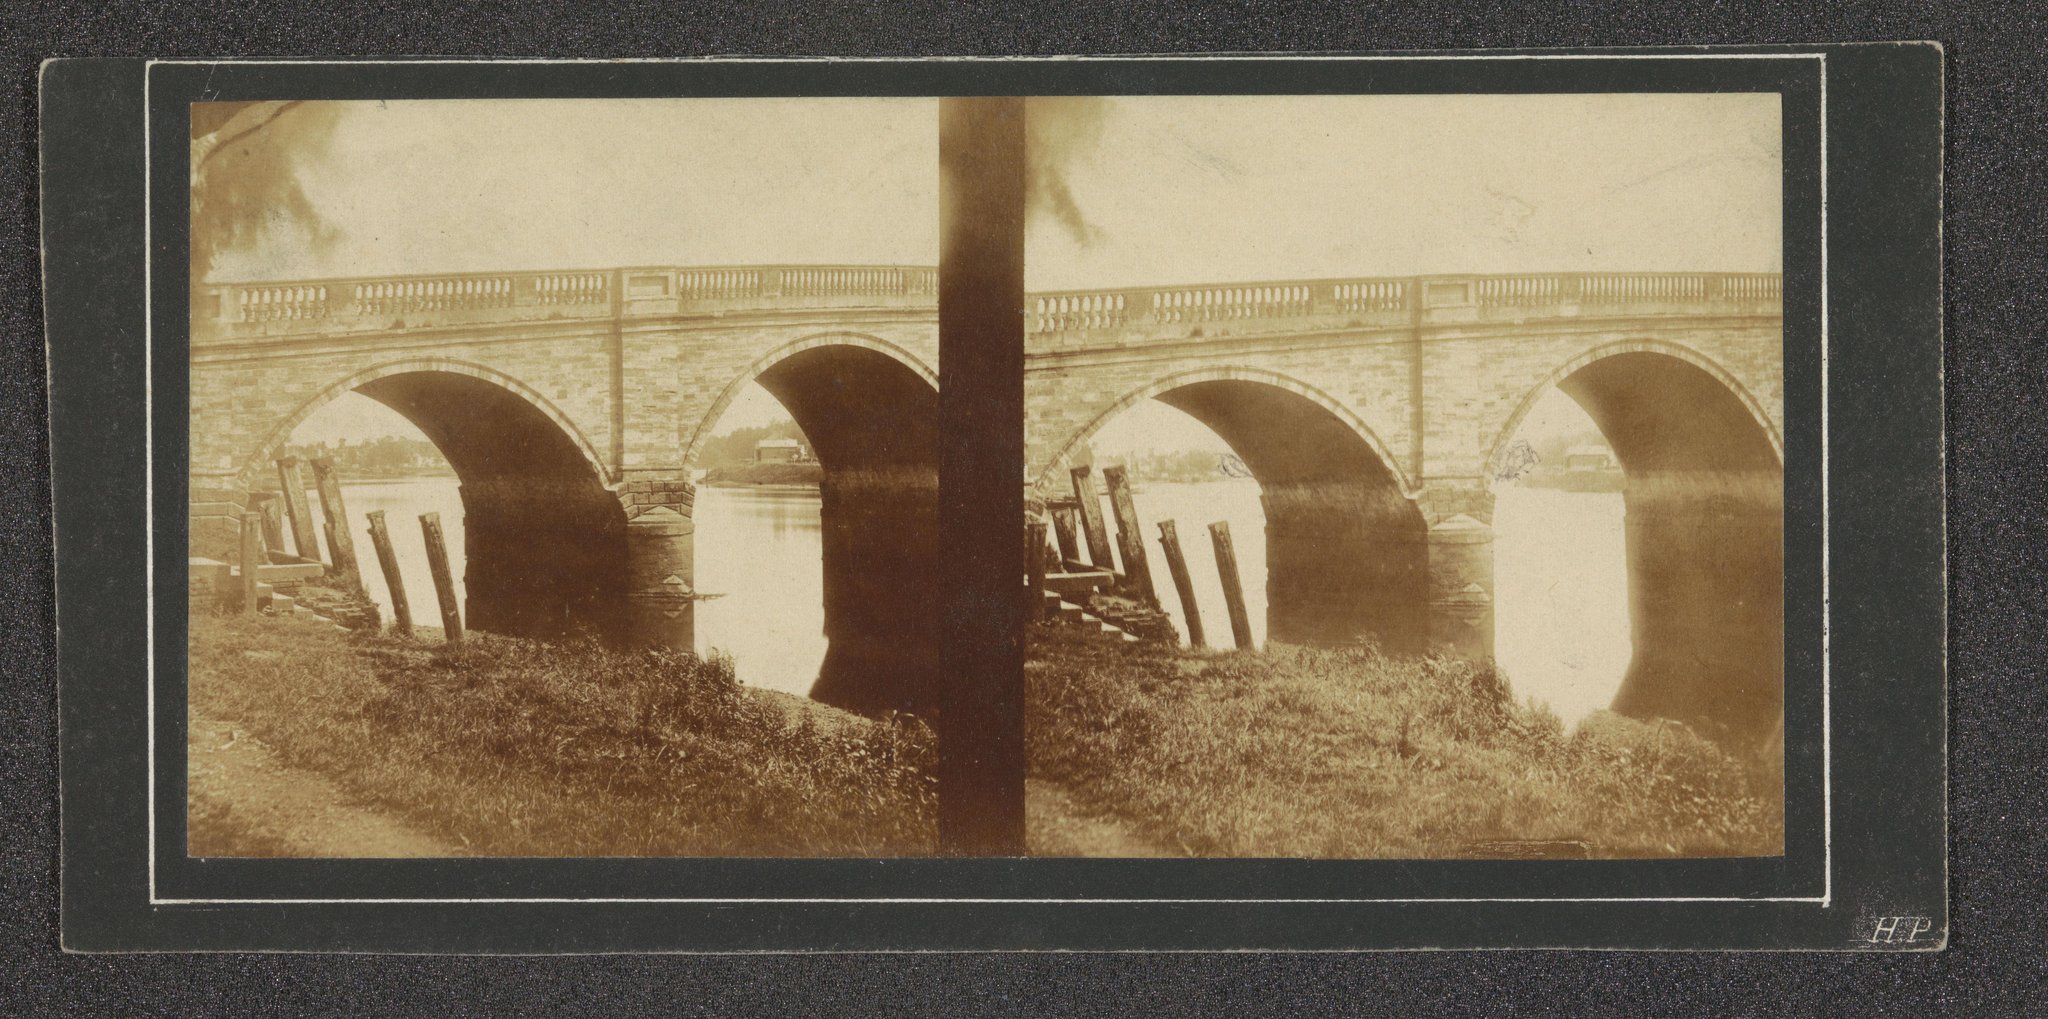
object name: stereograph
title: Brug met op de voorgrond een oever begroeid met gras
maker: charles-henri plaut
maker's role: publisher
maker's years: 1819-1870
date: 1864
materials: cardboard, paper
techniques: albumen print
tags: bridge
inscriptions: title: ‘Pont [...]’, signature: ‘J. Certifie H. Plaut’